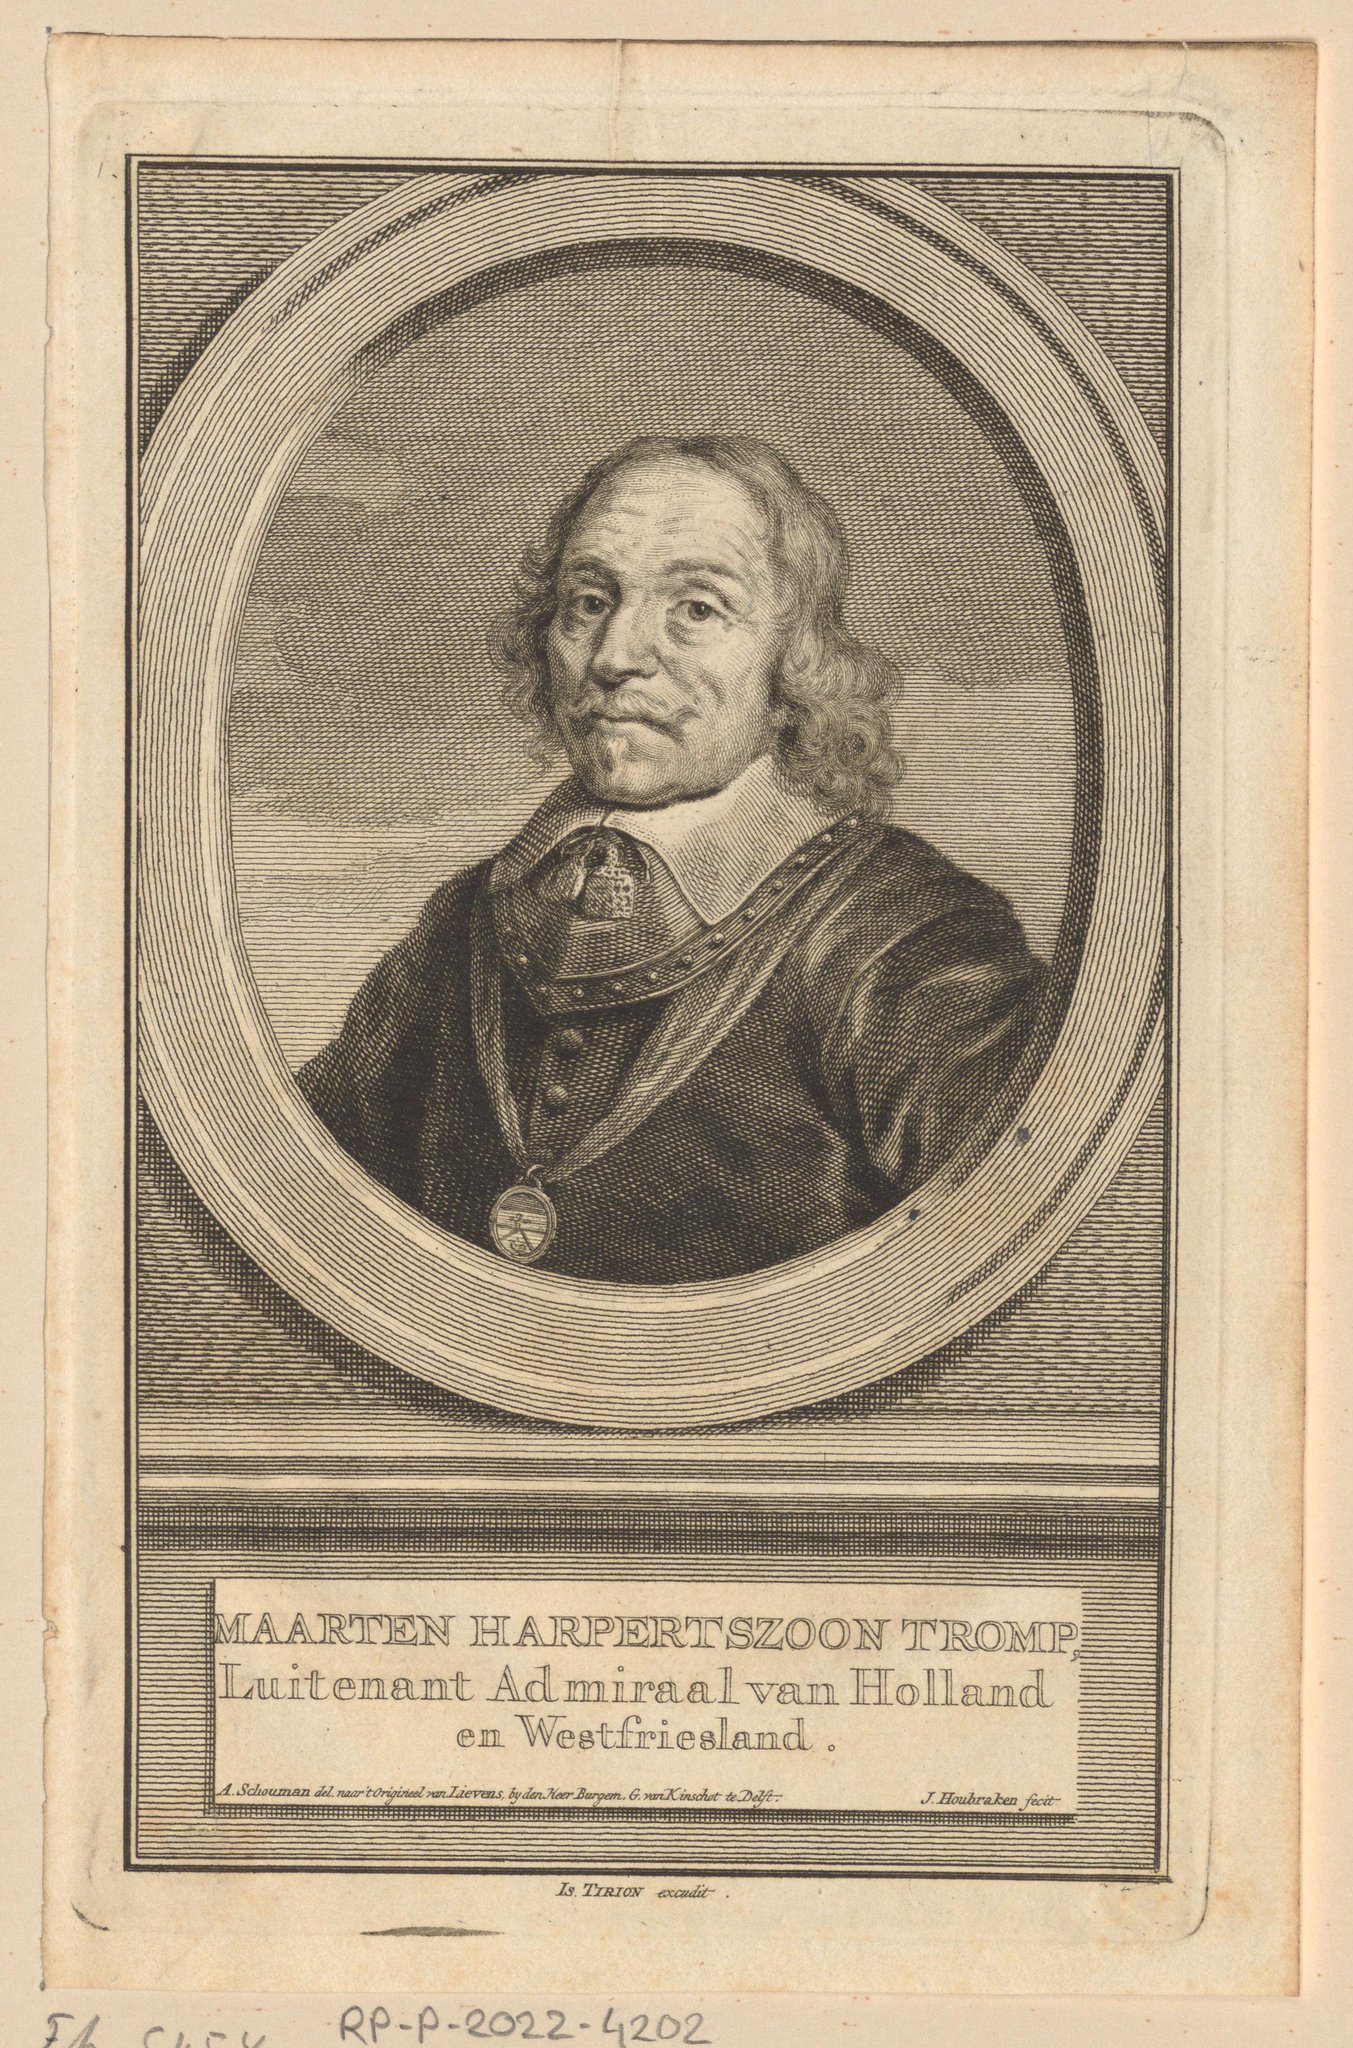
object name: print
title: Portret van Maarten Harpertszoon Tromp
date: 1749-1759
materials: paper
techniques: engraving, etching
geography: amsterdam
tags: brielle, maarten harpertszoon tromp, historical persons, medals and other marks of military honour, commander-in-chief, admiral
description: Prent waarschijnlijk uit: Wagenaar, Jan. Vaderlandsche historie, vervattende de geschiedenissen der nu Vereenigde Nederlanden, inzonderheid die van Holland (...), Amsterdam: Isaak Tirion, 1749-59, dl. 12, p. 242.